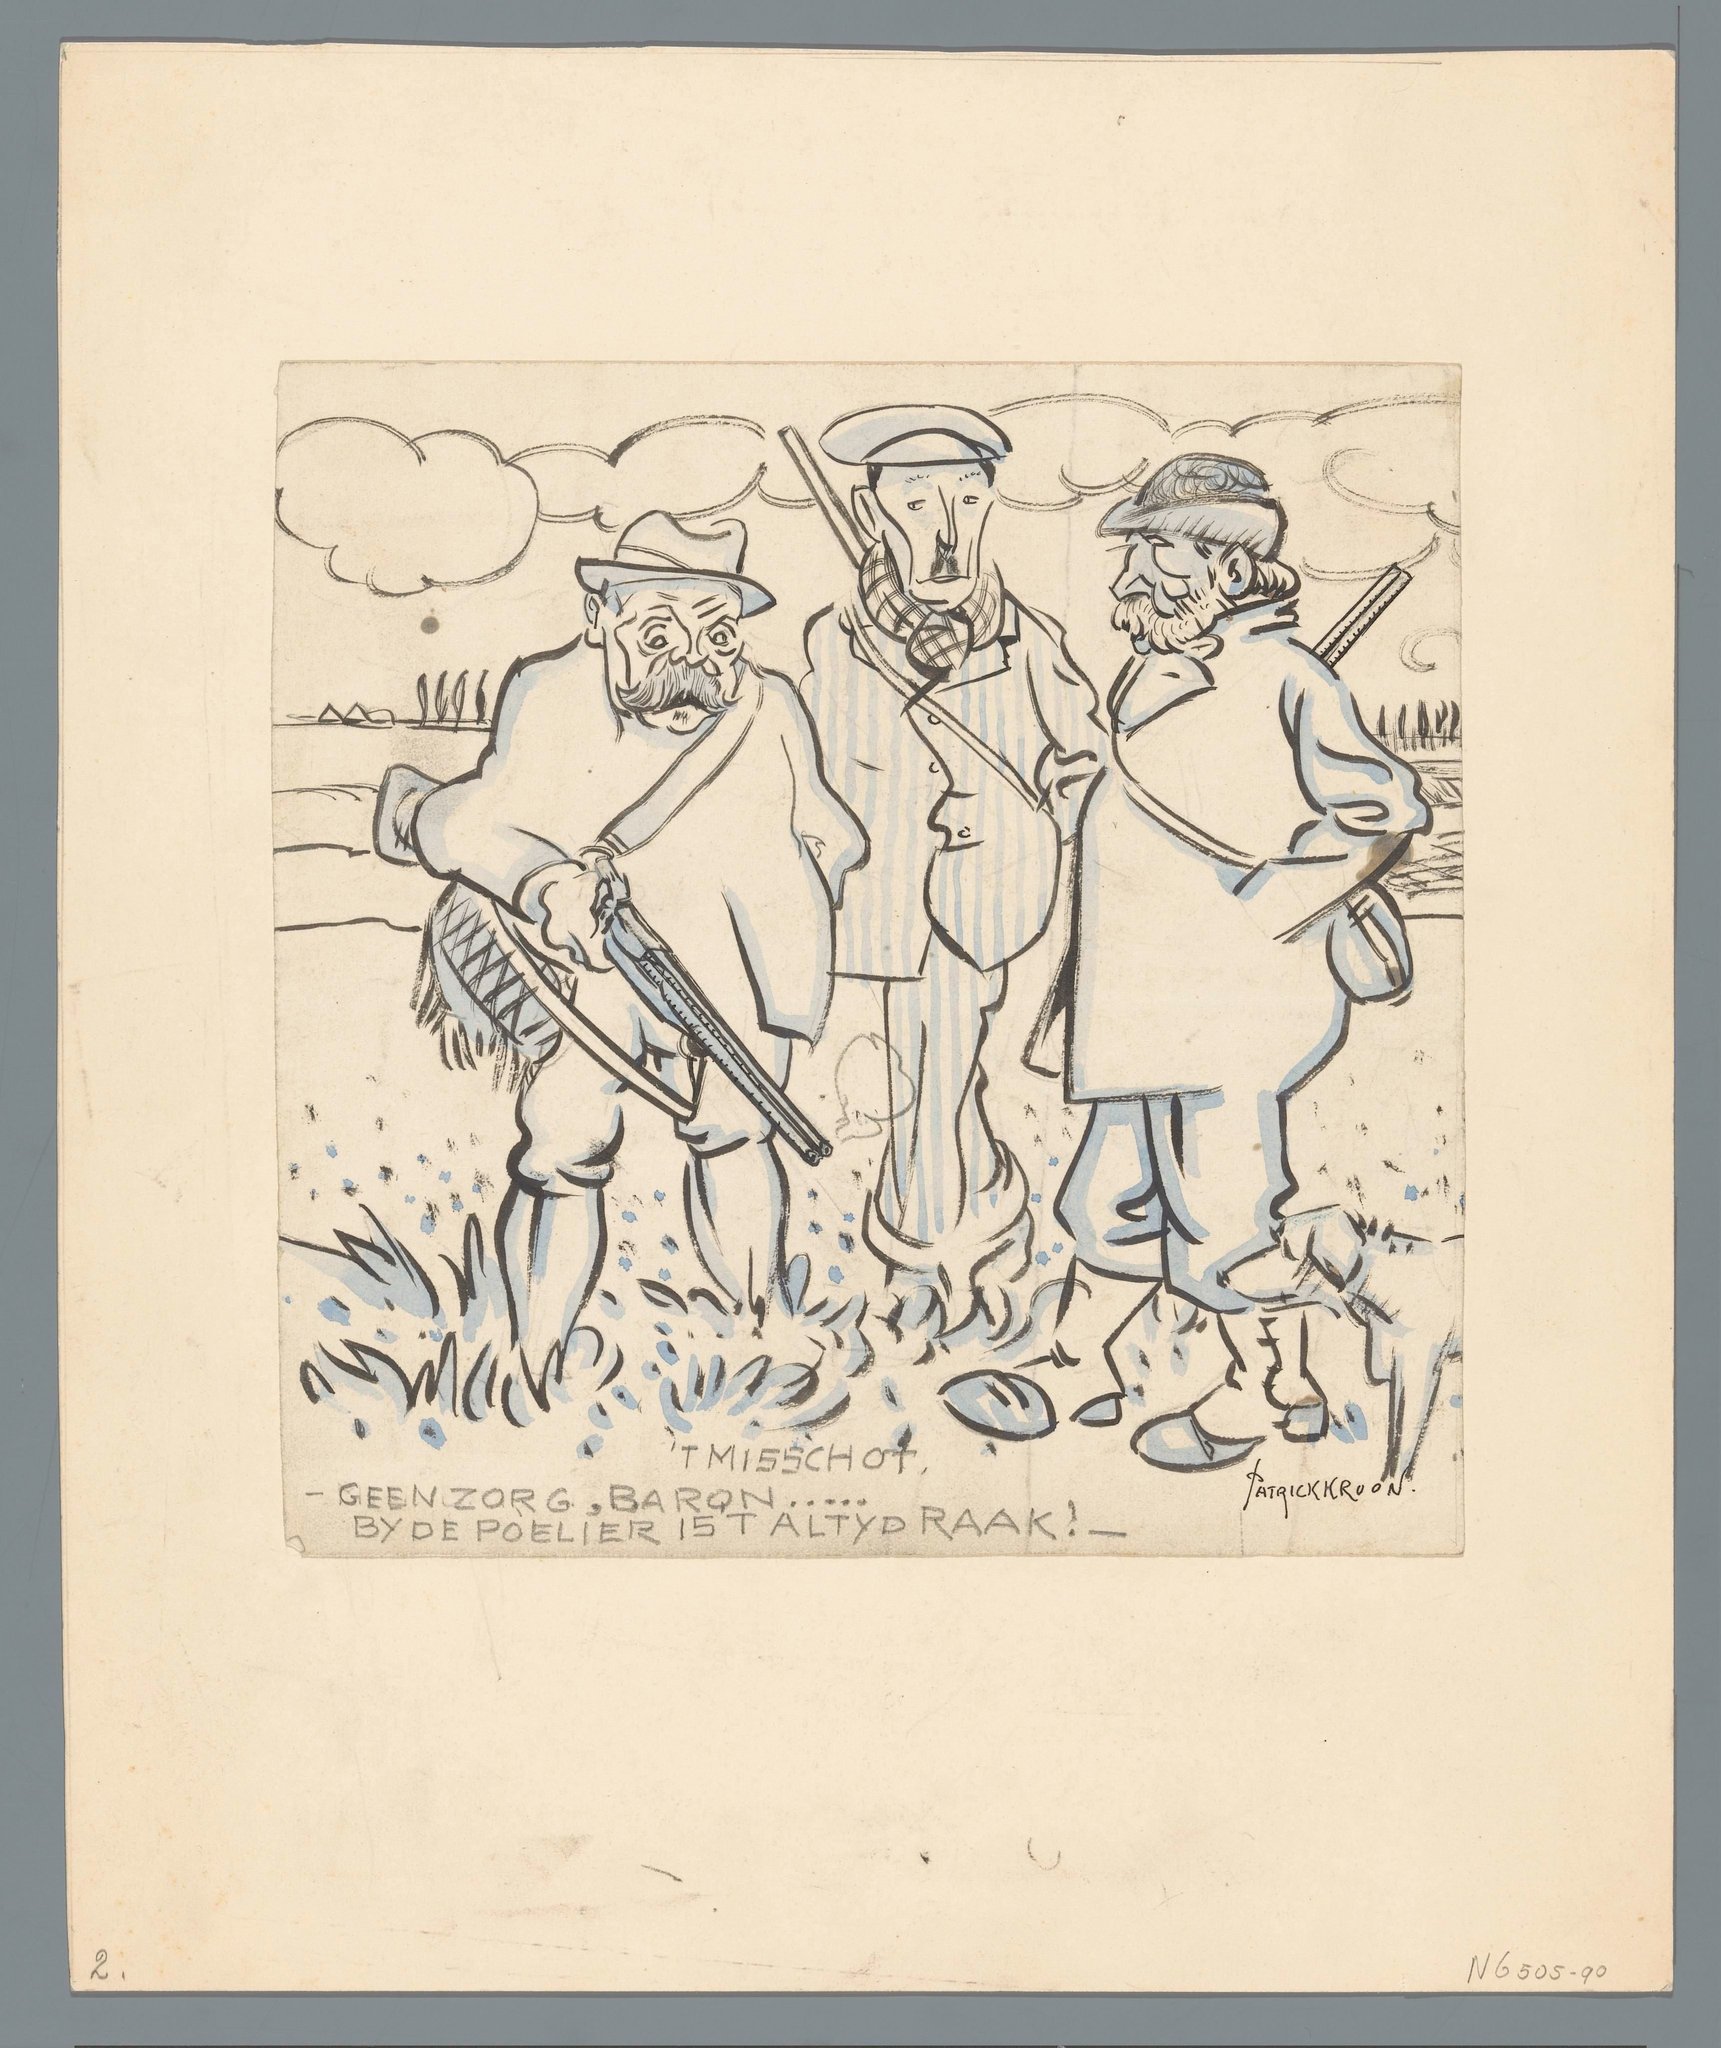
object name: drawing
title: Drie jagers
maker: patricq kroon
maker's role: draughtsman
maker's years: 1862-1941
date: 1900-1935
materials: ink, paint, paper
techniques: brush, pen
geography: netherlands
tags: hunter, political caricatures and satires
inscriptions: inscription: ‘'t Misschot. - Geen zorg, baron ... by de poelier is 't altijd raak! -’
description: Drie jagers in een veld. Ontwerp voor een cartoon in de krant.